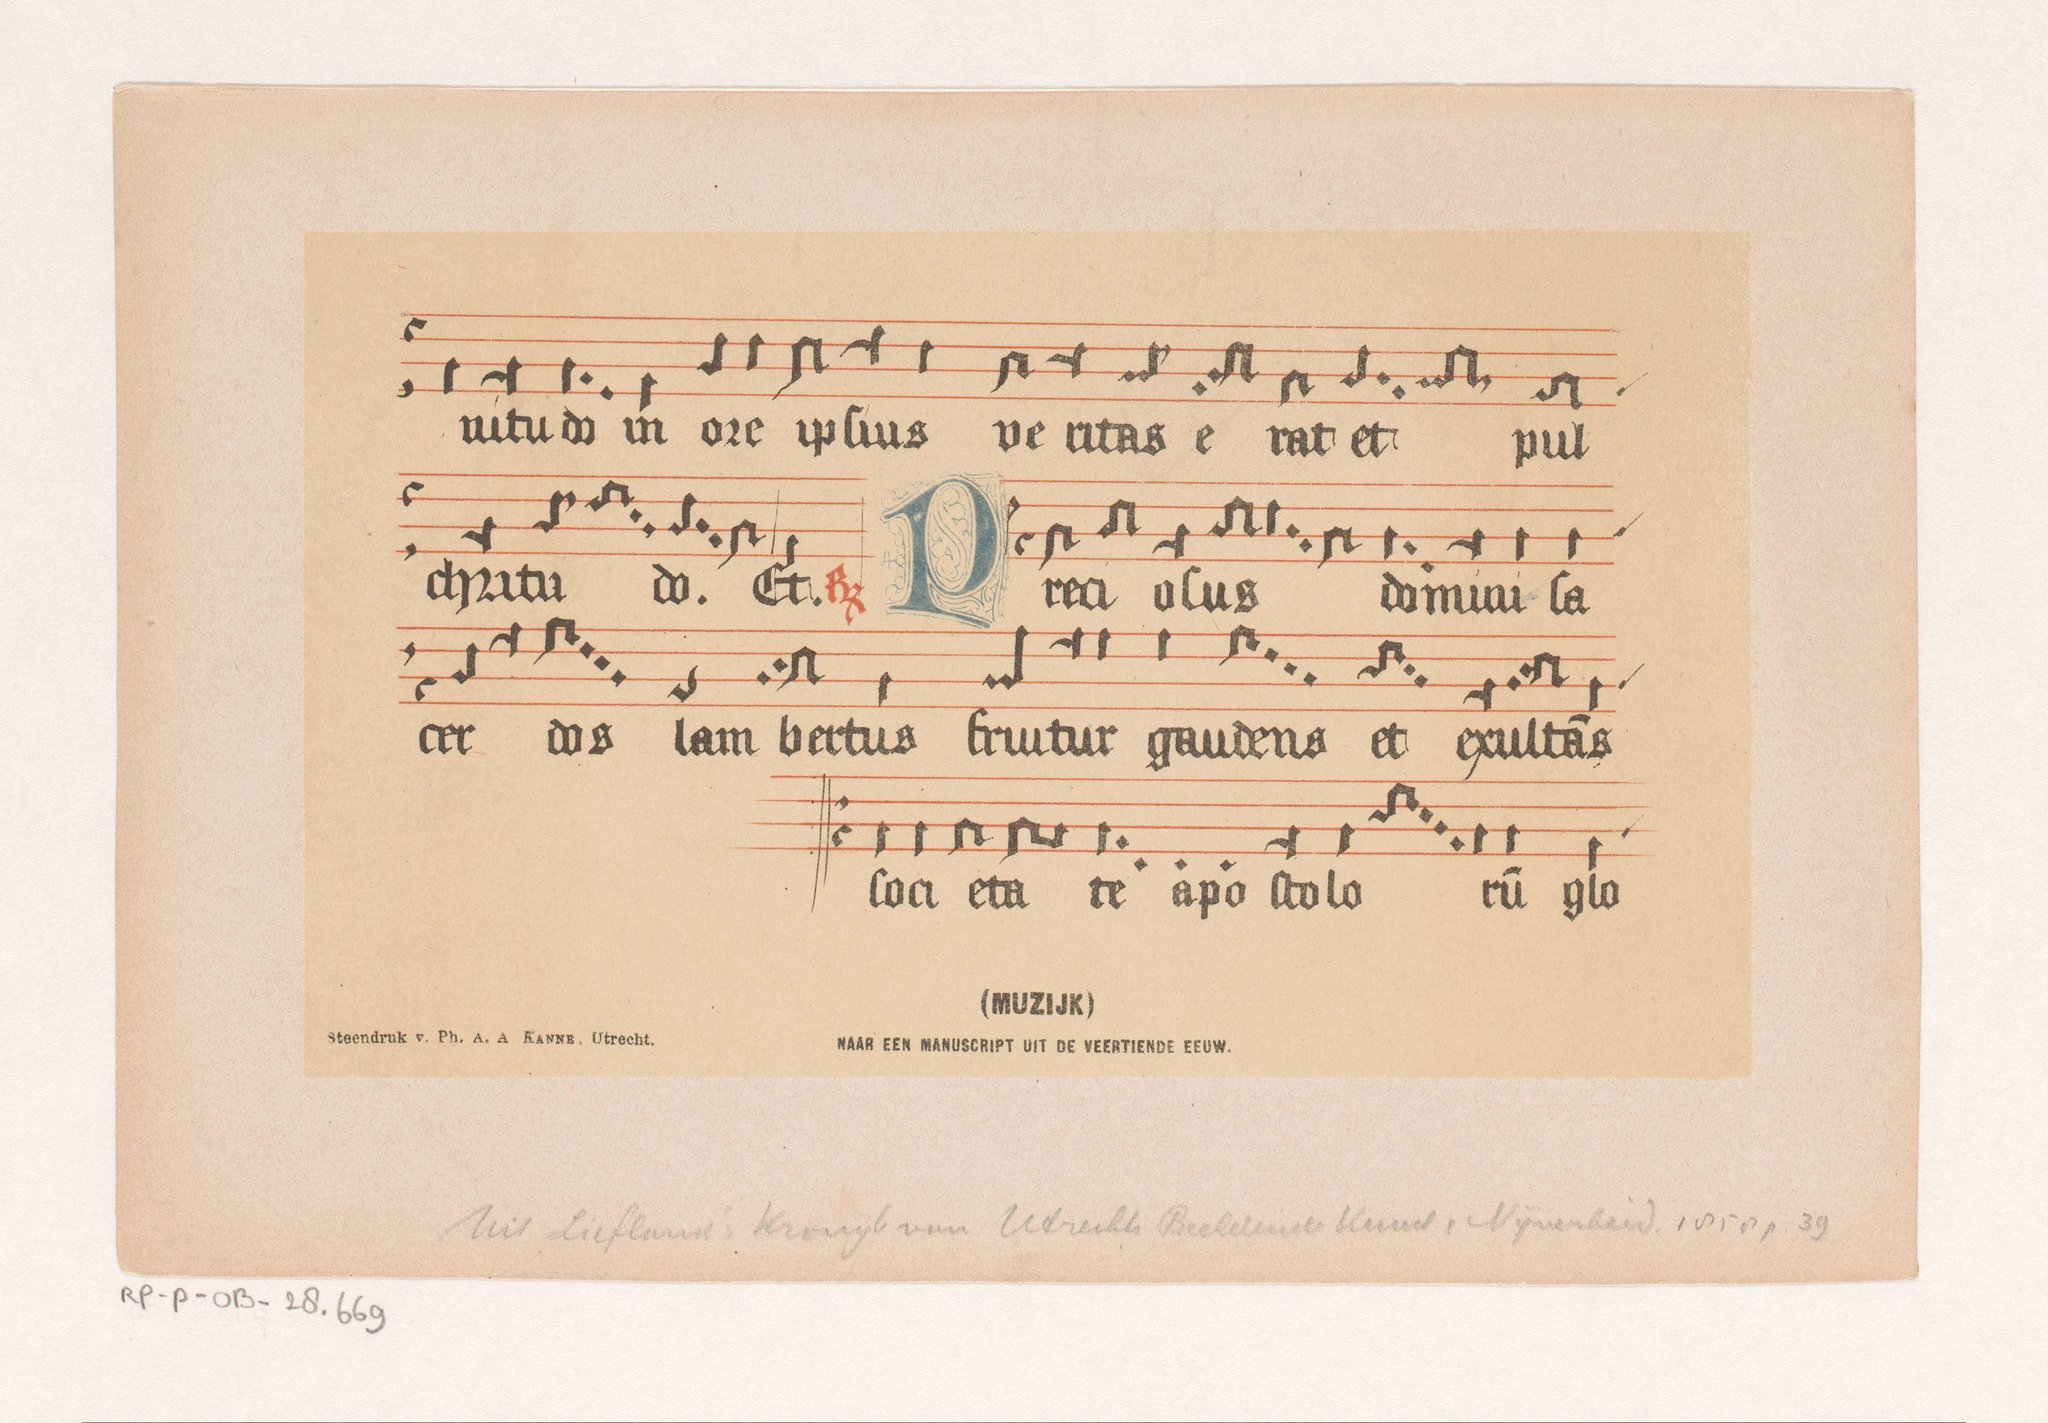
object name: print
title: Muziekschrift uit de veertiende eeuw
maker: philippus anthonius alexander kanne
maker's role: draughtsman, print maker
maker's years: 1833-1872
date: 1858-1860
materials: paper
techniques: lithograph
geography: utrecht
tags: notation of music, manuscript of musical score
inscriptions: inscription: ‘Uit Lieflands Kronijk van Utrechts Beeldende Kunst, Nijverheid. 1858 p. 39’, collector's mark: Lugt 2228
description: Volgens het opschrift op het recto is deze prent afkomstig uit: Liefland, J. van 'Kronijk voor Utrechts Beeldende Kunst en Nijverheid' Utrecht, P.W. van de Weijer, 1858-1860.